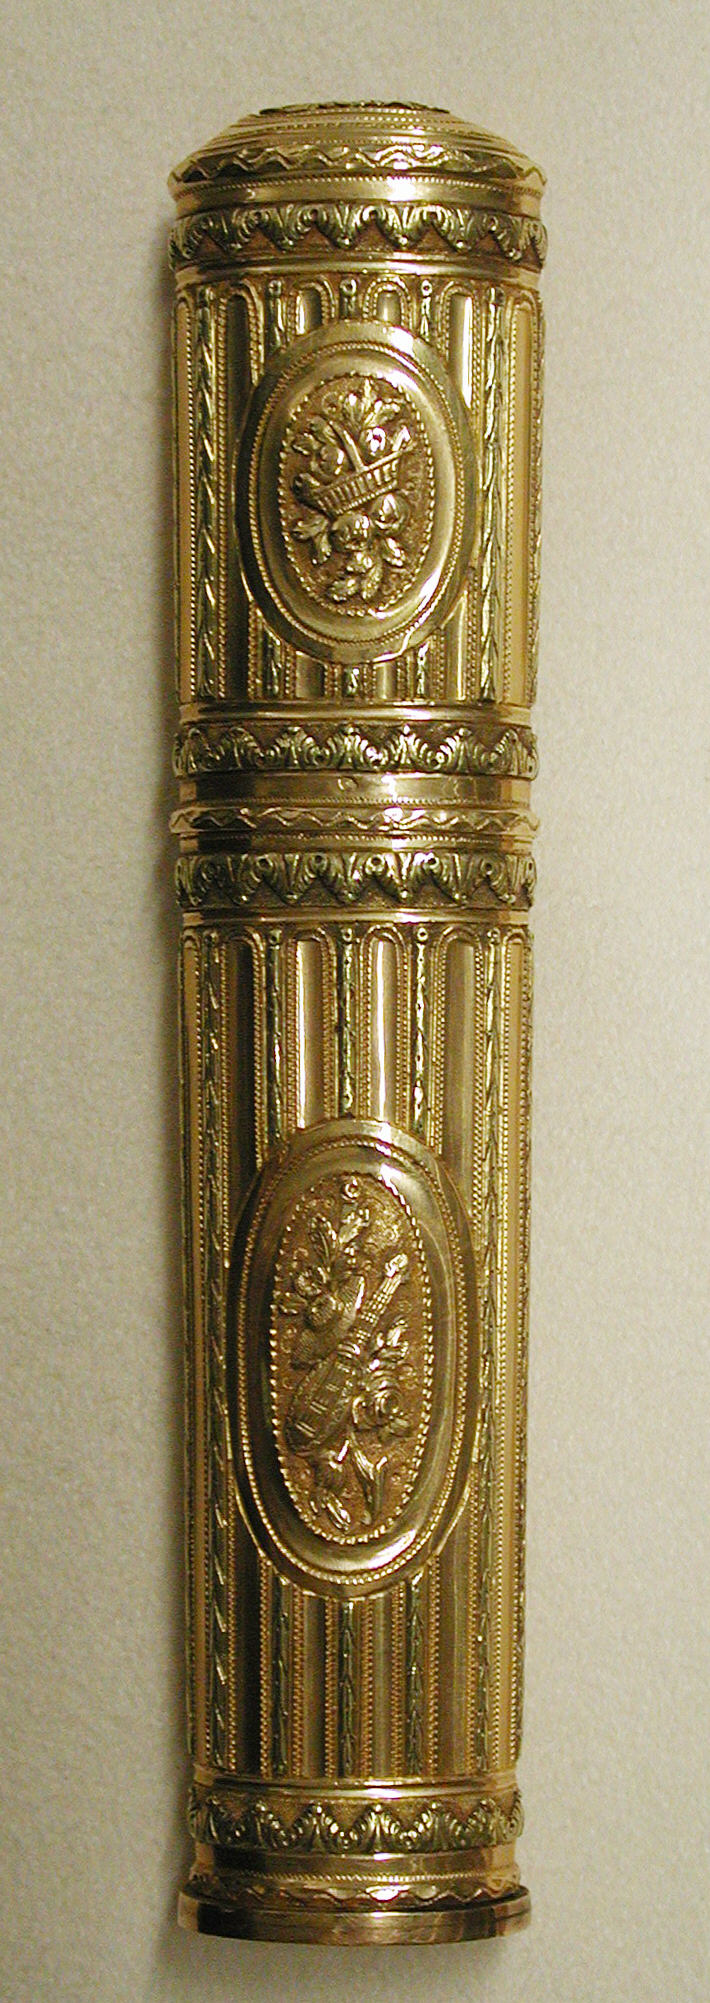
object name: étui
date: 1772-1773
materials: gold